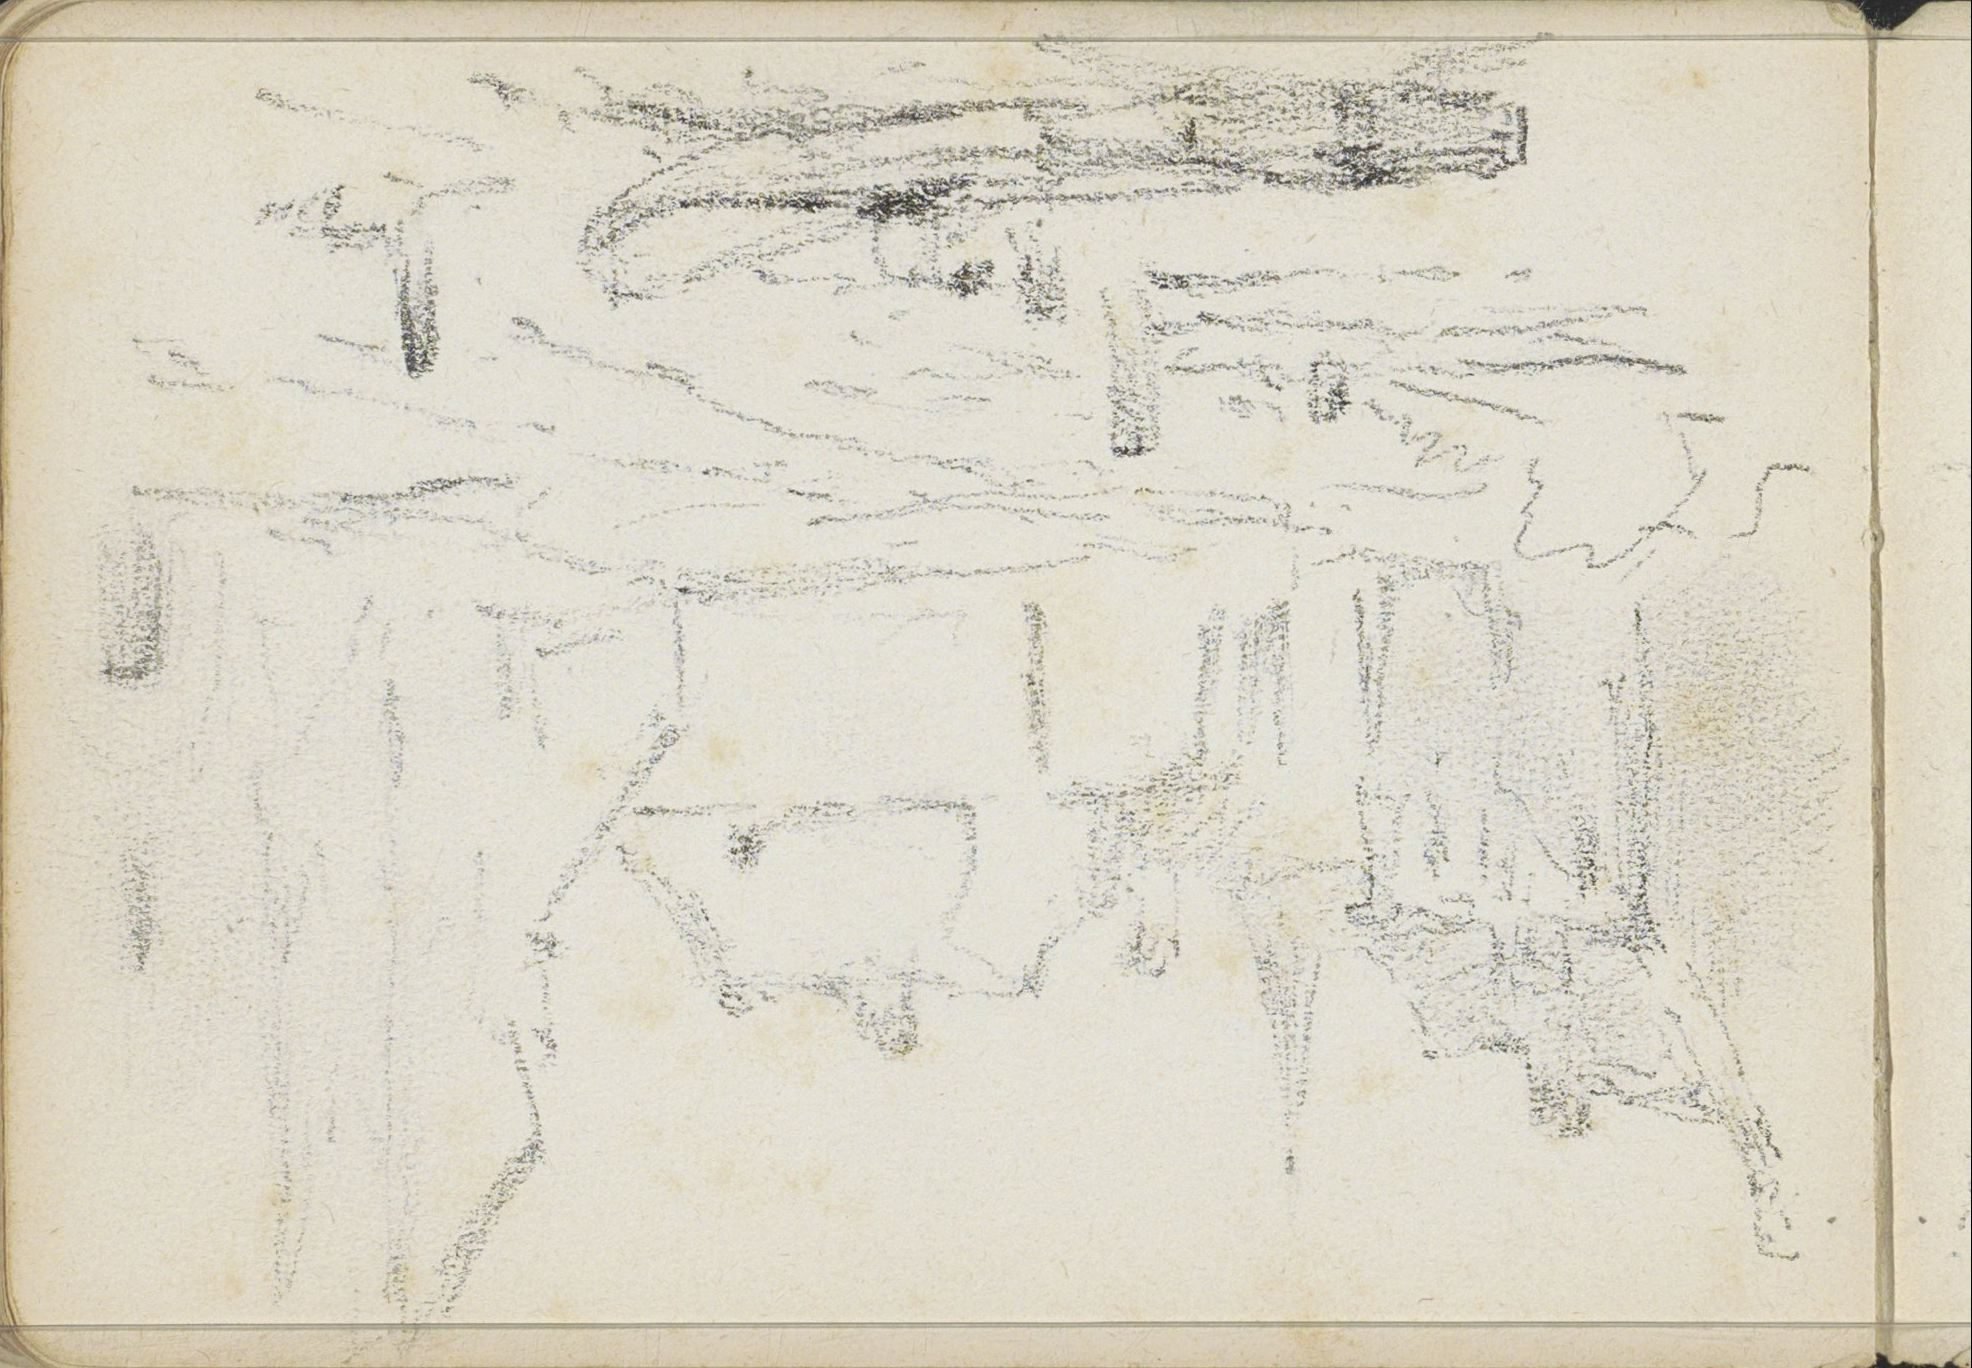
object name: sketchbook leaf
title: Dorpsstraat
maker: willem cornelis rip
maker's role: draughtsman, painter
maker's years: 1856-1922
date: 1866-1922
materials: chalk, paper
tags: village street, rowing-boat, canoe, etc.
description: Op de voorgrond ligt een roeiboot op een kade. Blad 42 verso uit een schetsboek met 42 bladen.